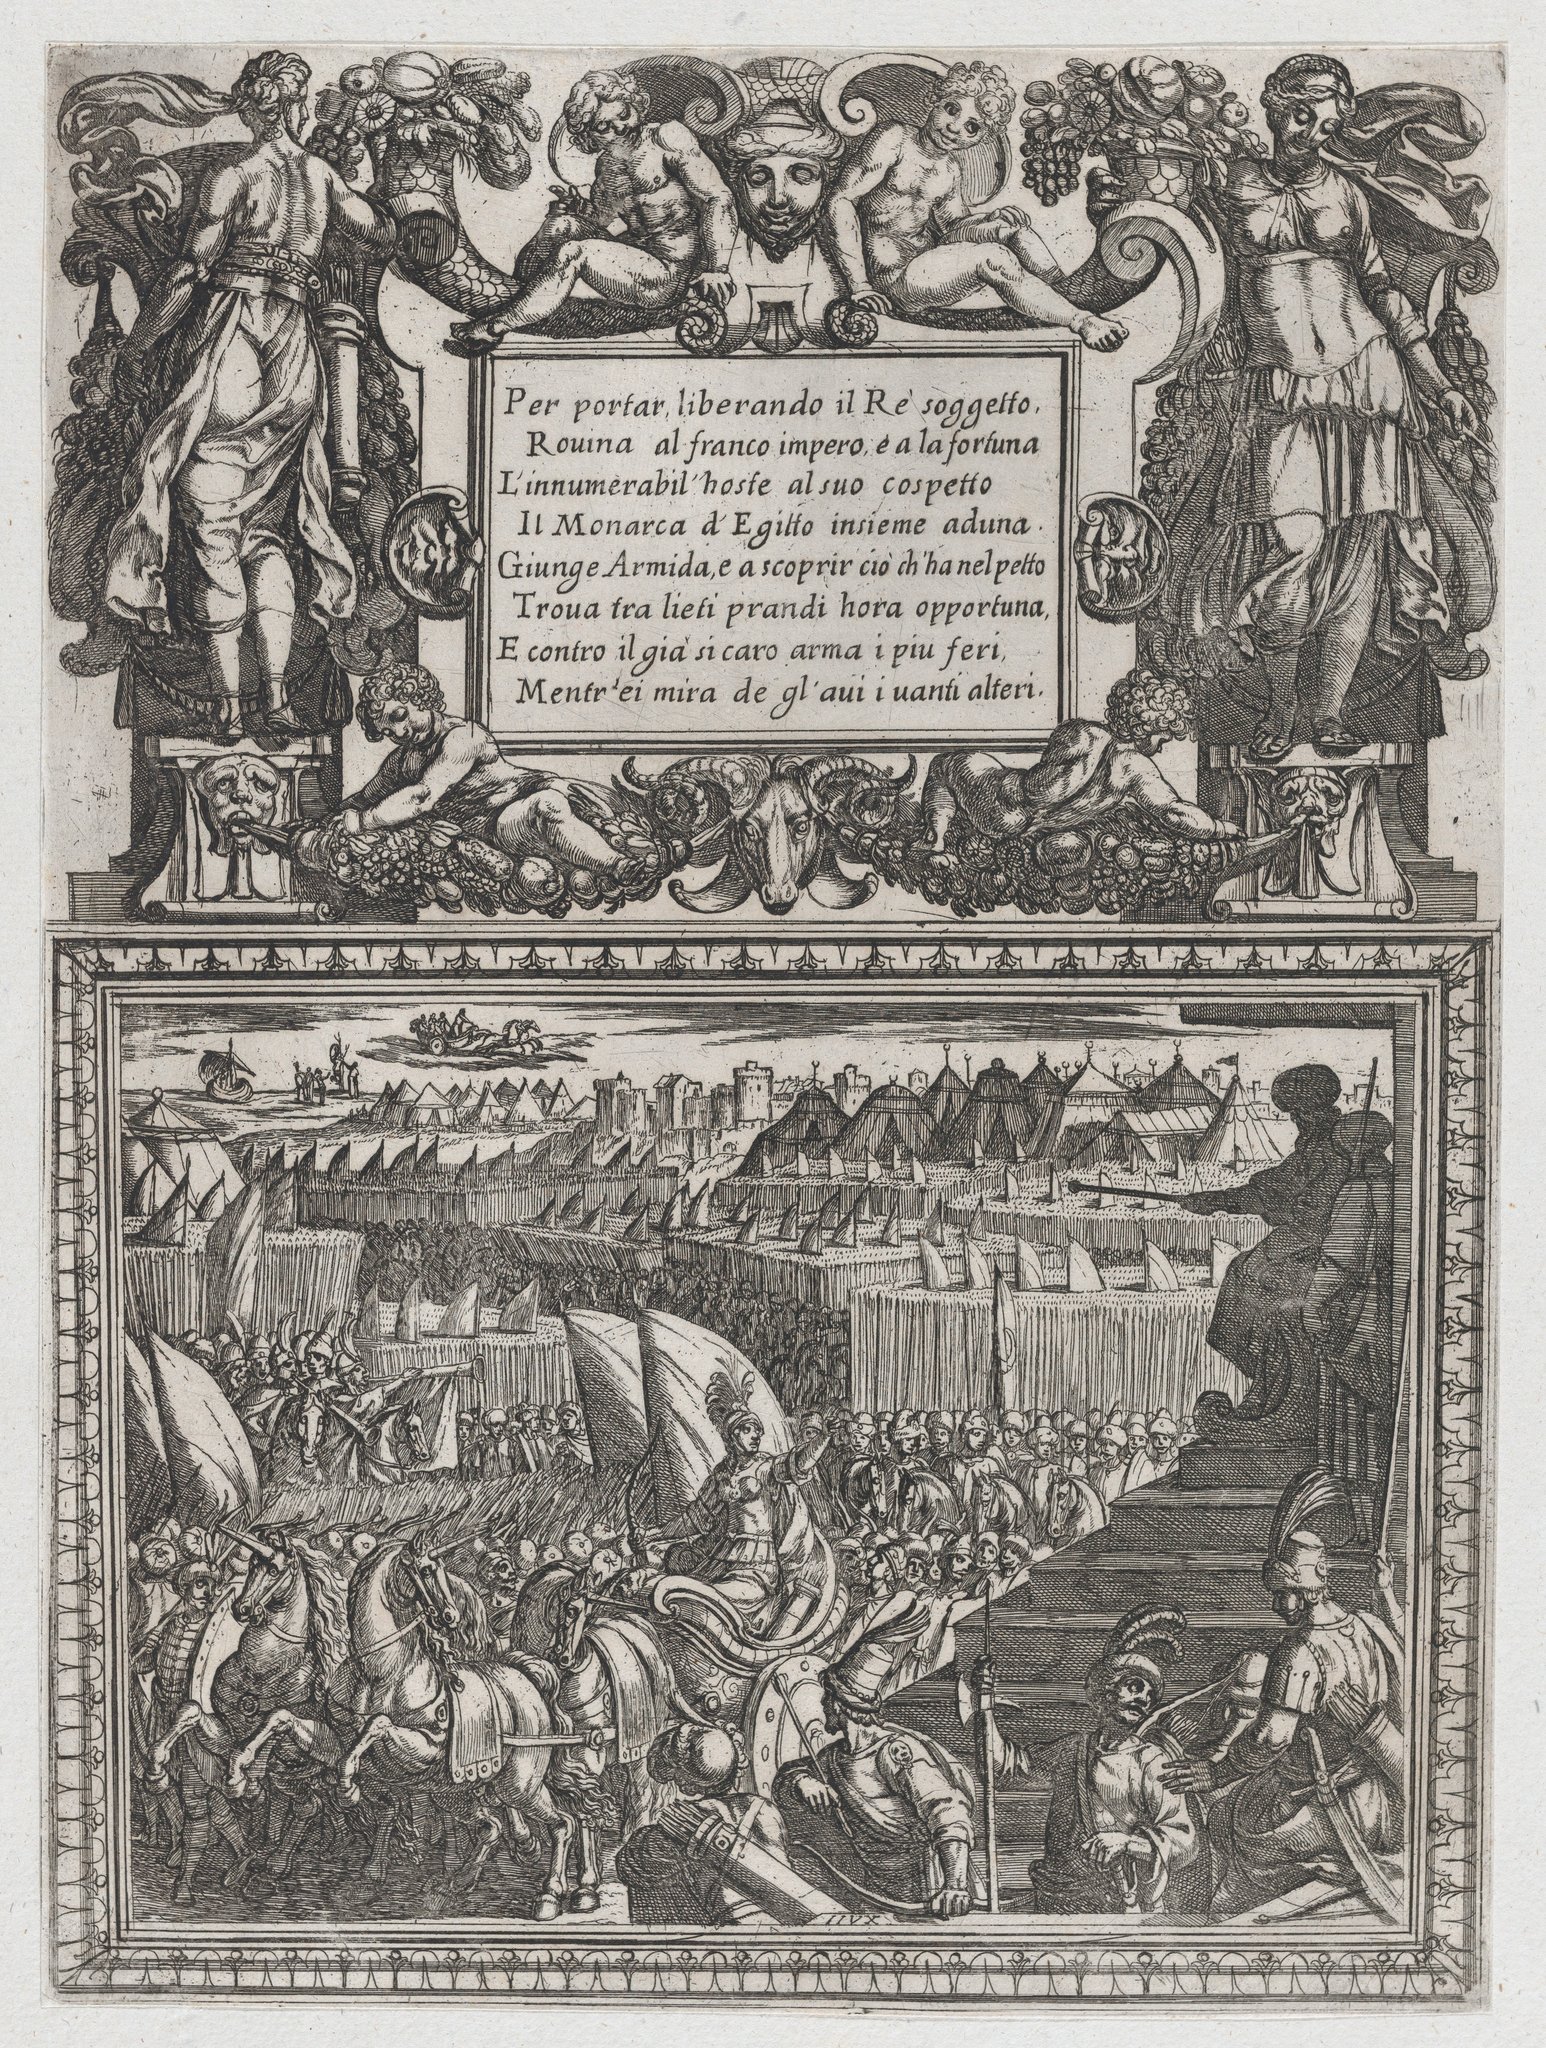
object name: print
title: Plate 17: Illustration to Canto XVII, from Torquato Tasso's "Gerusalemme liberata III"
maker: antonio tempesta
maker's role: artist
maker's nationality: italian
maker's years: 1555-1630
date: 1590-1630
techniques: etching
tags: tents,soldiers,bow and arrow,women,horses